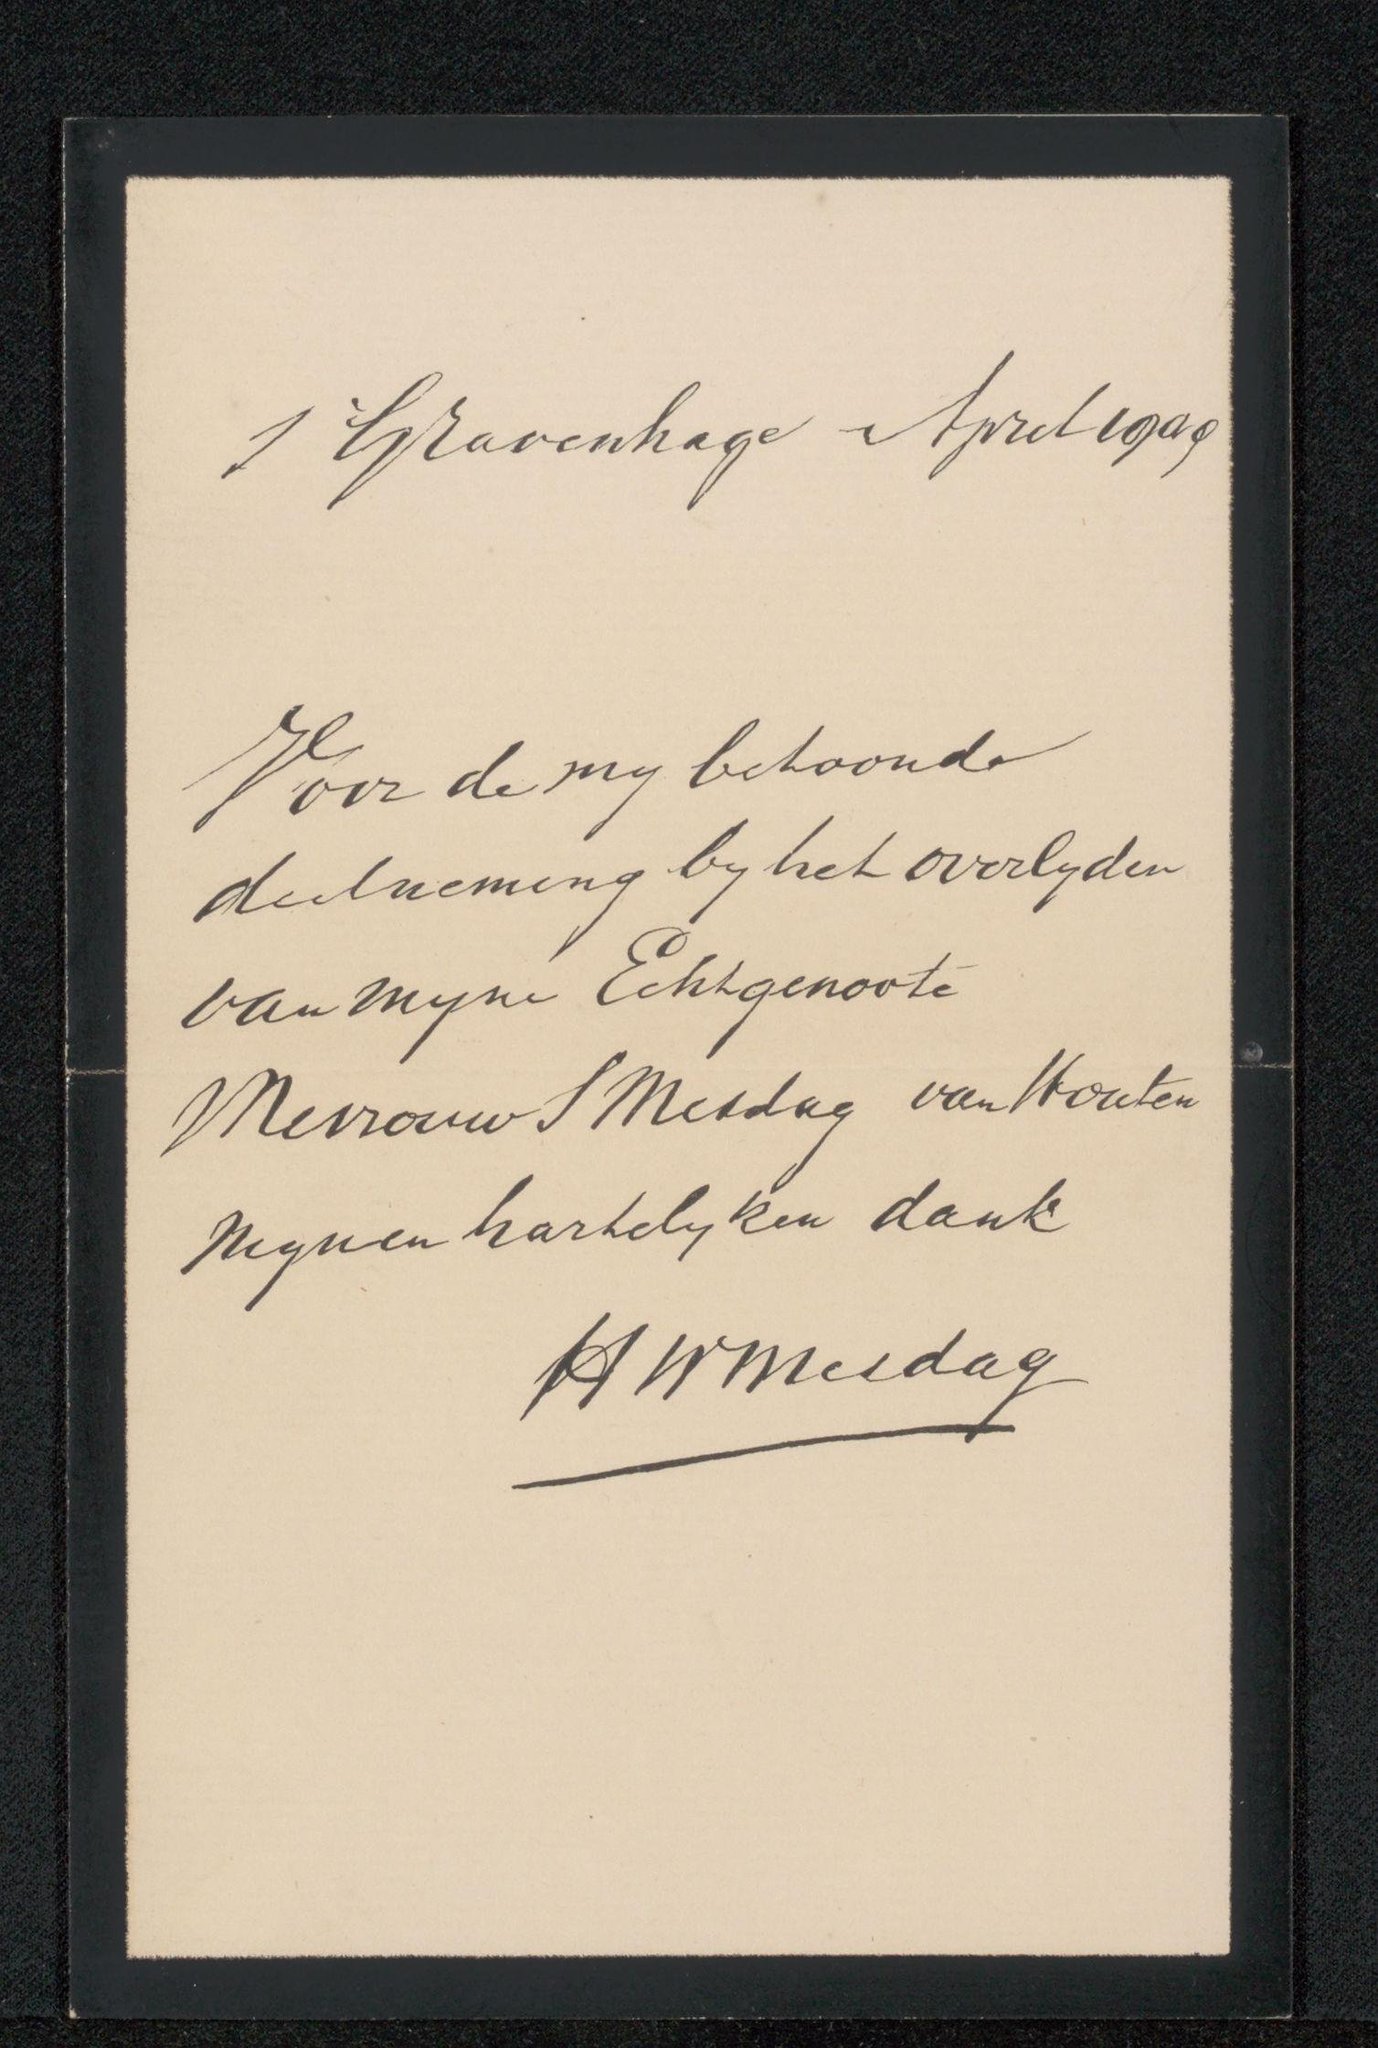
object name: letter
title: Brief aan Philip Zilcken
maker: hendrik willem mesdag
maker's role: draughtsman, painter, print maker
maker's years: 1831-1915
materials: ink, paper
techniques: pen, writing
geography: the hague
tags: sientje mesdag-van houten, philip zilcken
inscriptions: collector's mark: ‘RPK’